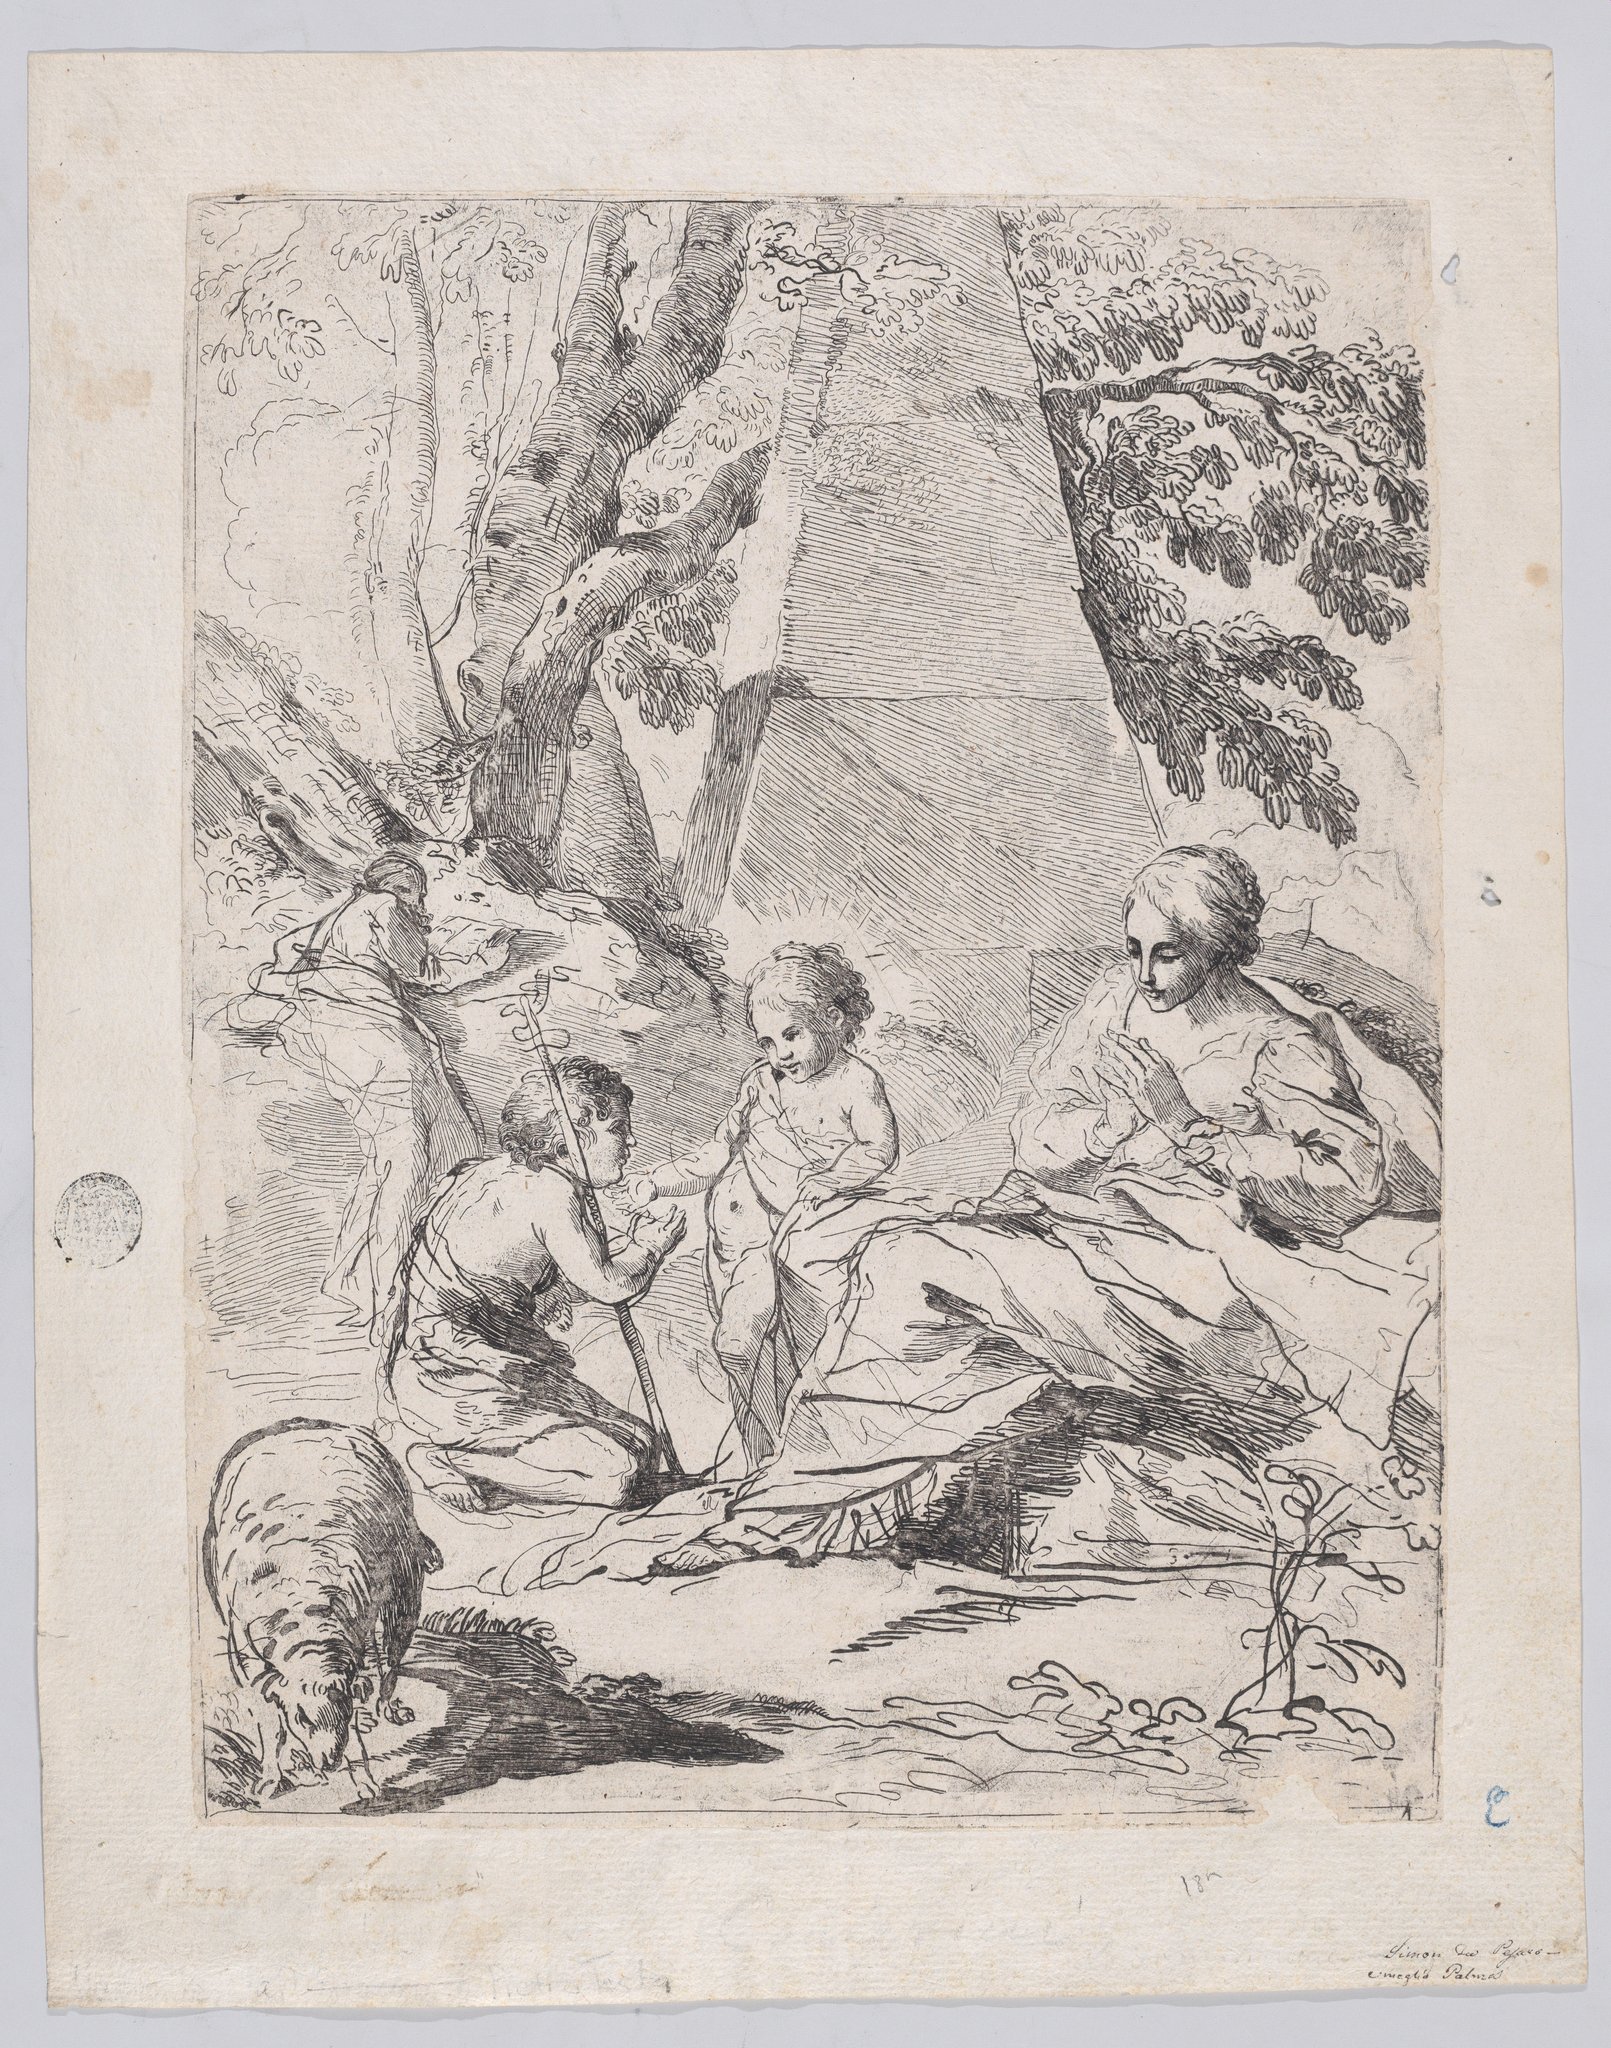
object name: print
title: The Virgin at the right with the Christ Child and St John the Baptist at left, a pyramid structure in the background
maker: anonymous, 18th century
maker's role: artist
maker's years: 1700-1800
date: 1700-1800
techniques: etching